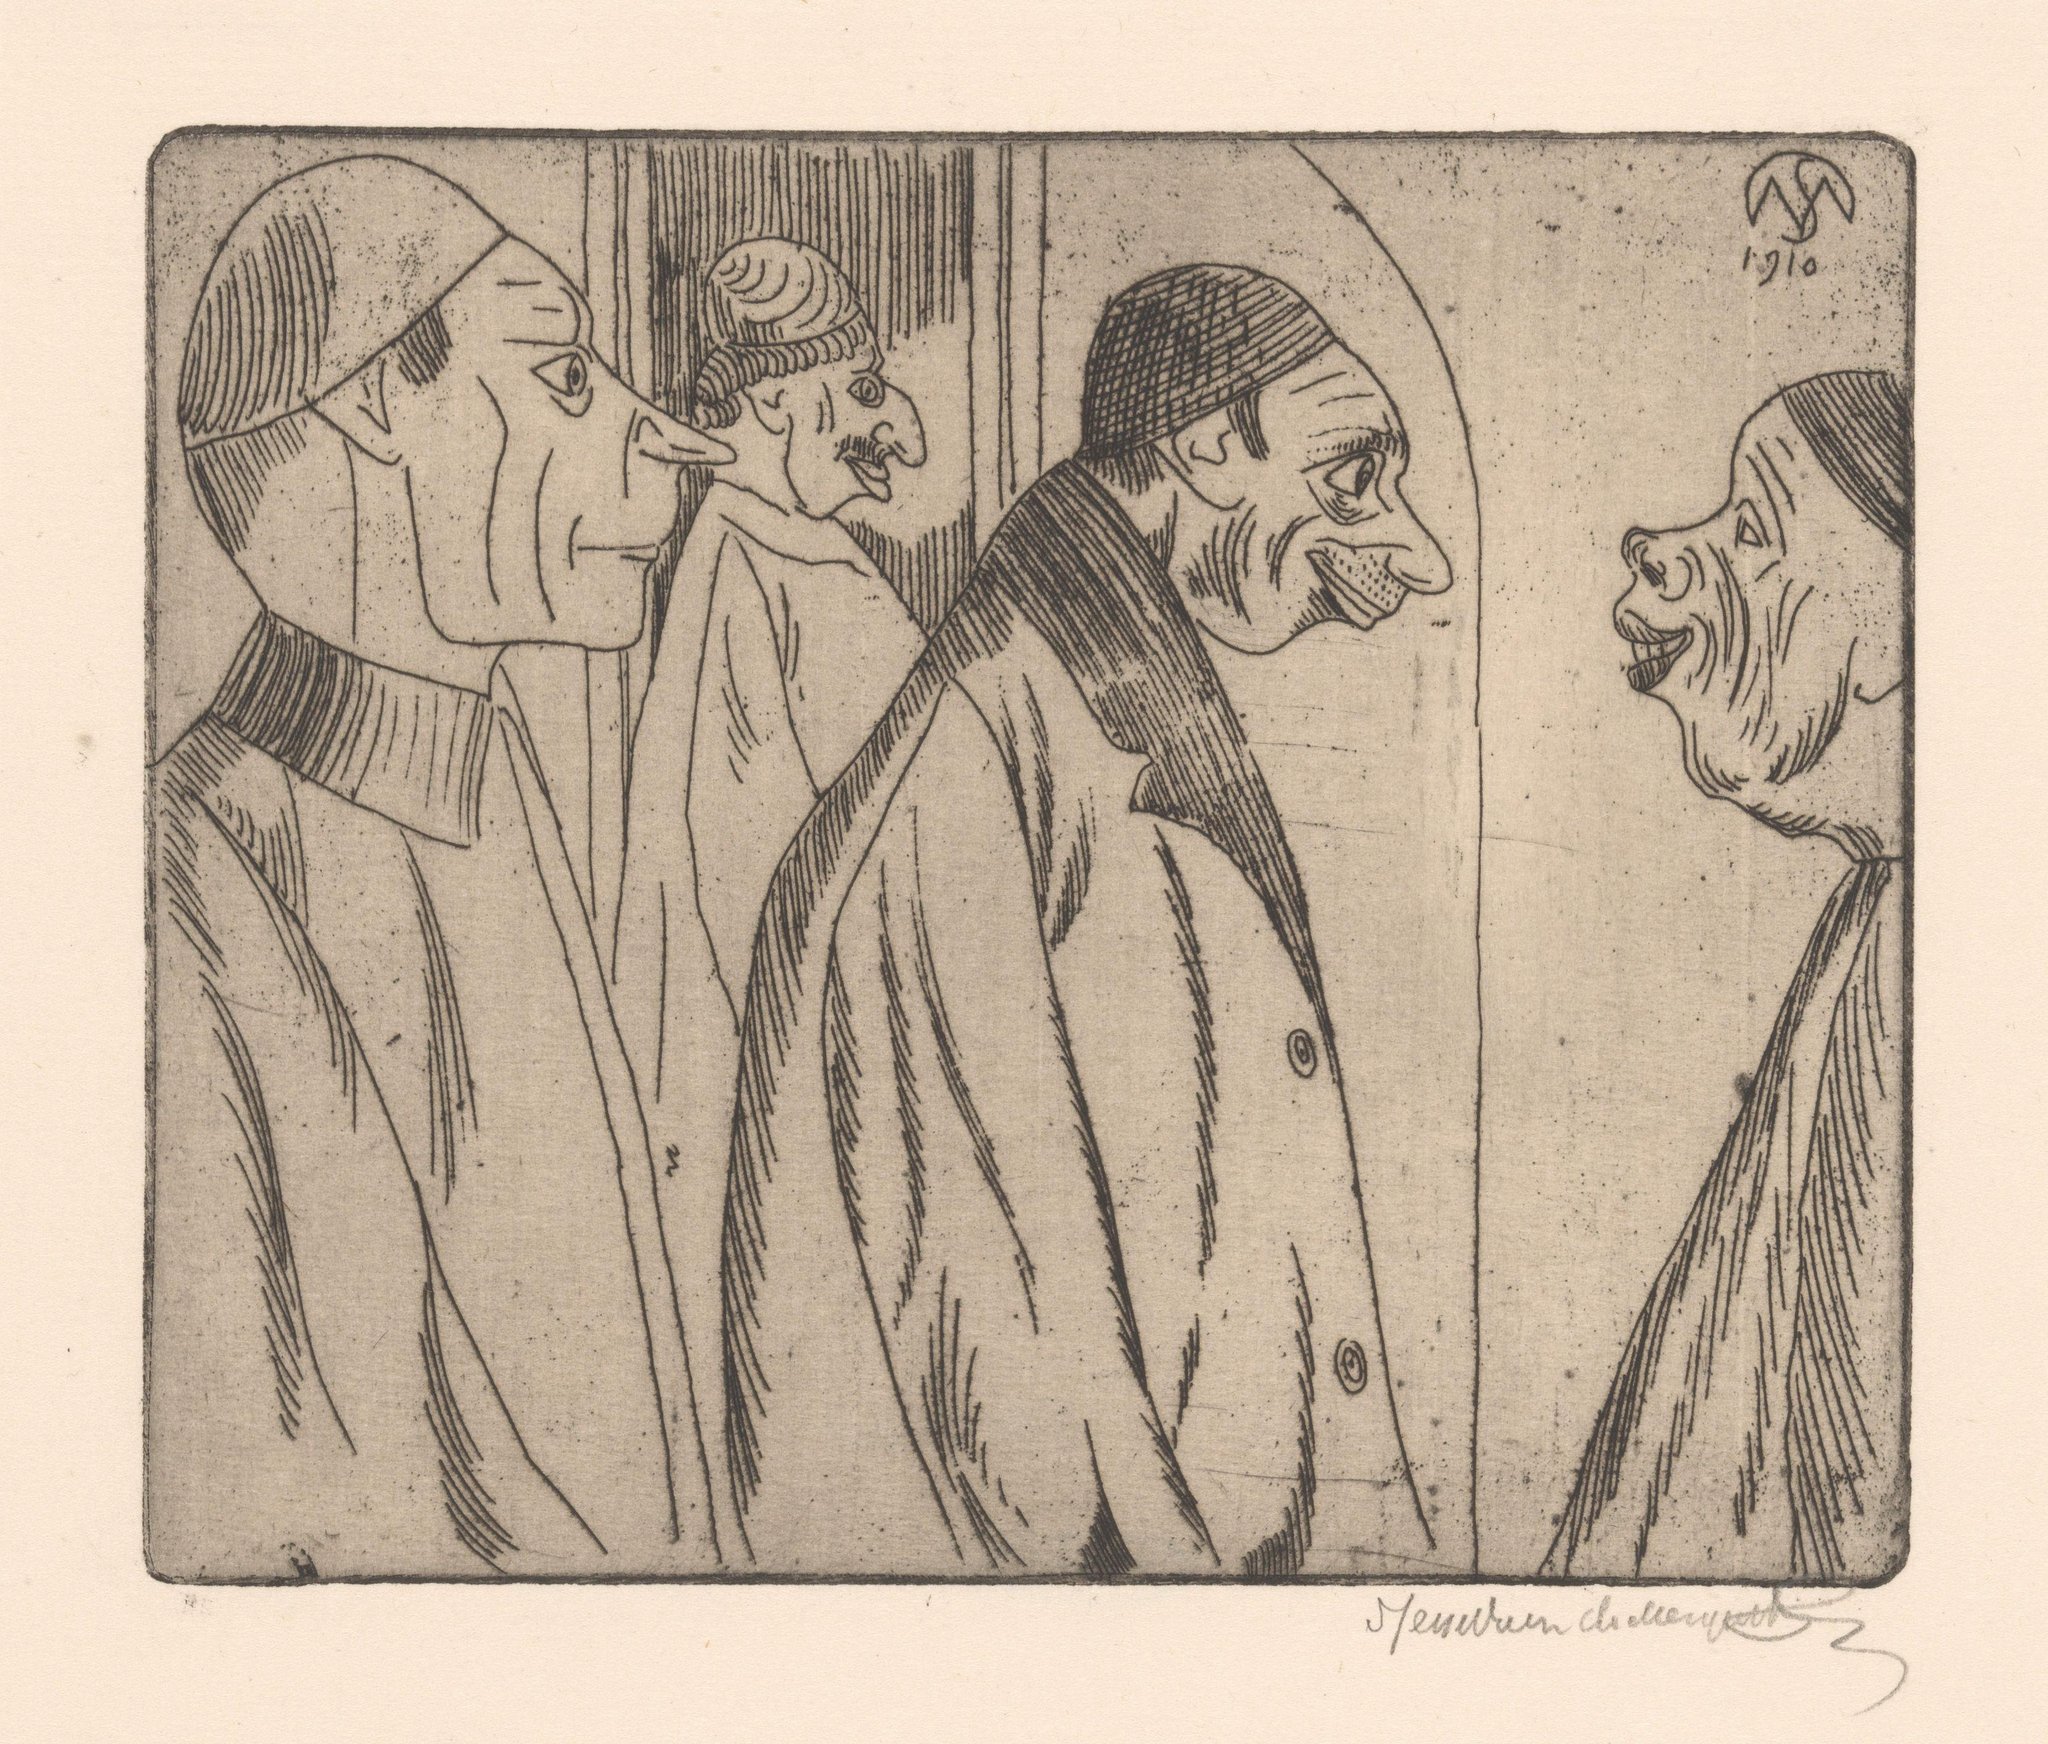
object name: print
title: Groteske verbeelding: vier figuren in profiel, waarvan er drie naar rechts zijn gekeerd en één naar links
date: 1910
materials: paper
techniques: etching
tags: caricatures (human types), head-gear: hat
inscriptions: collector's mark: Lugt 2228